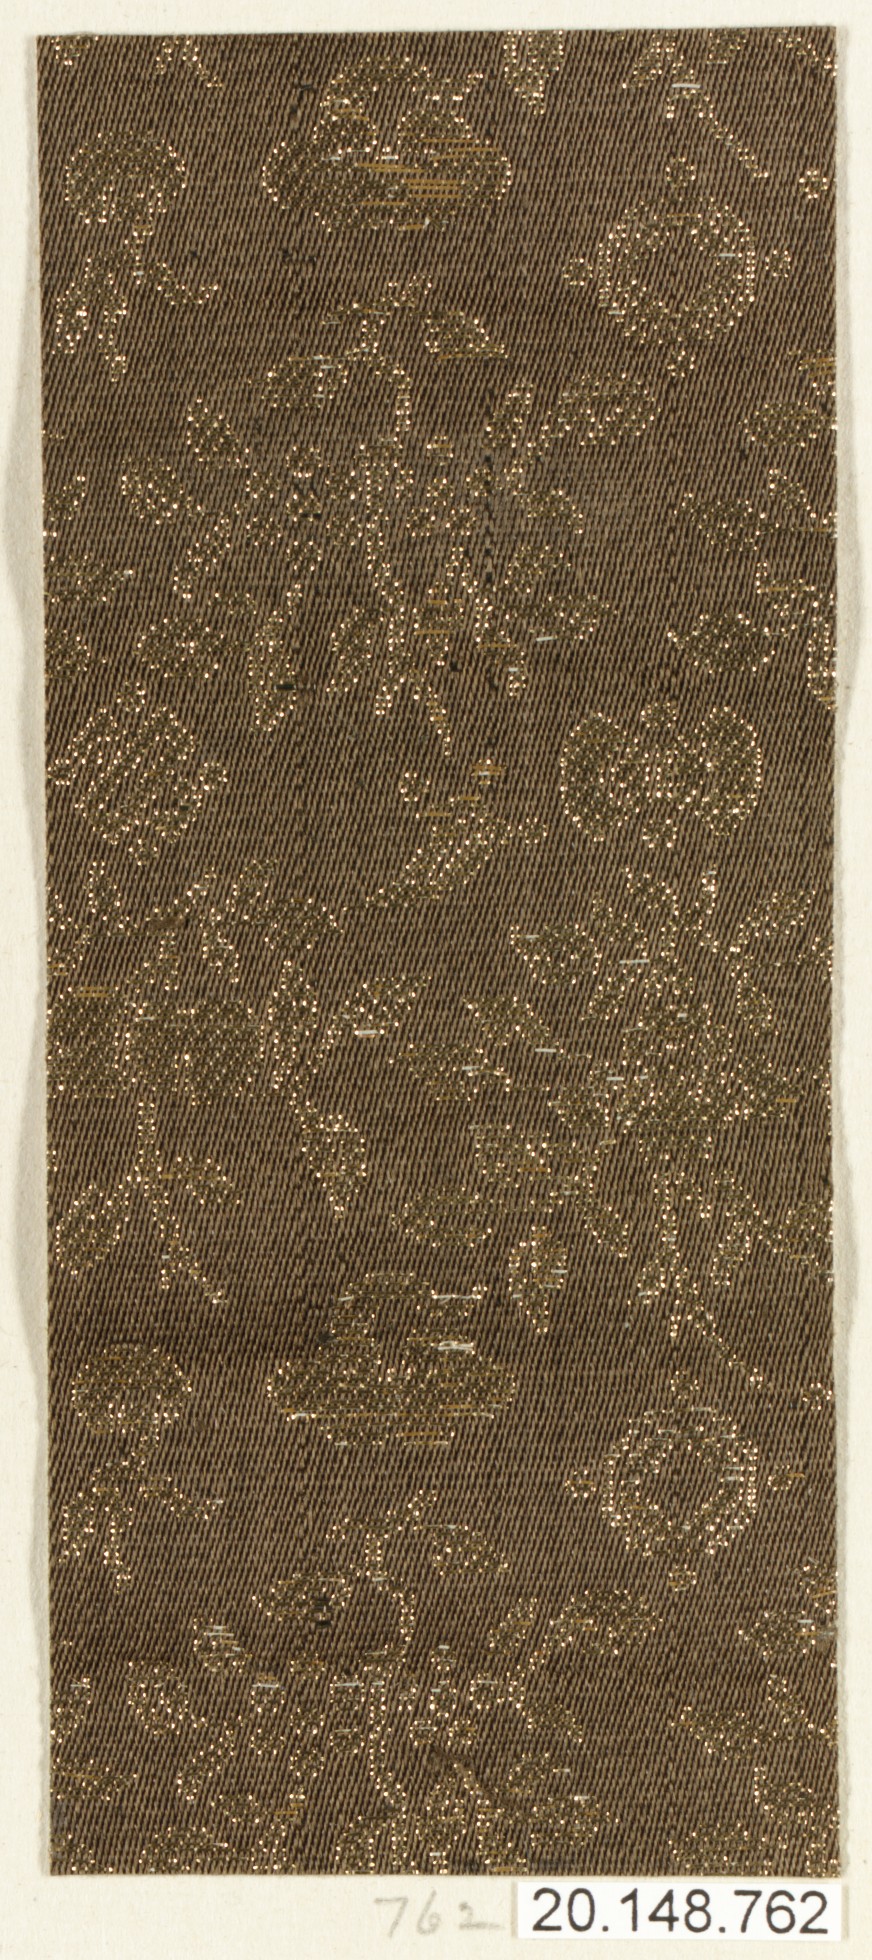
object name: piece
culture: japanese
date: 1601-1700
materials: silk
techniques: compound weave